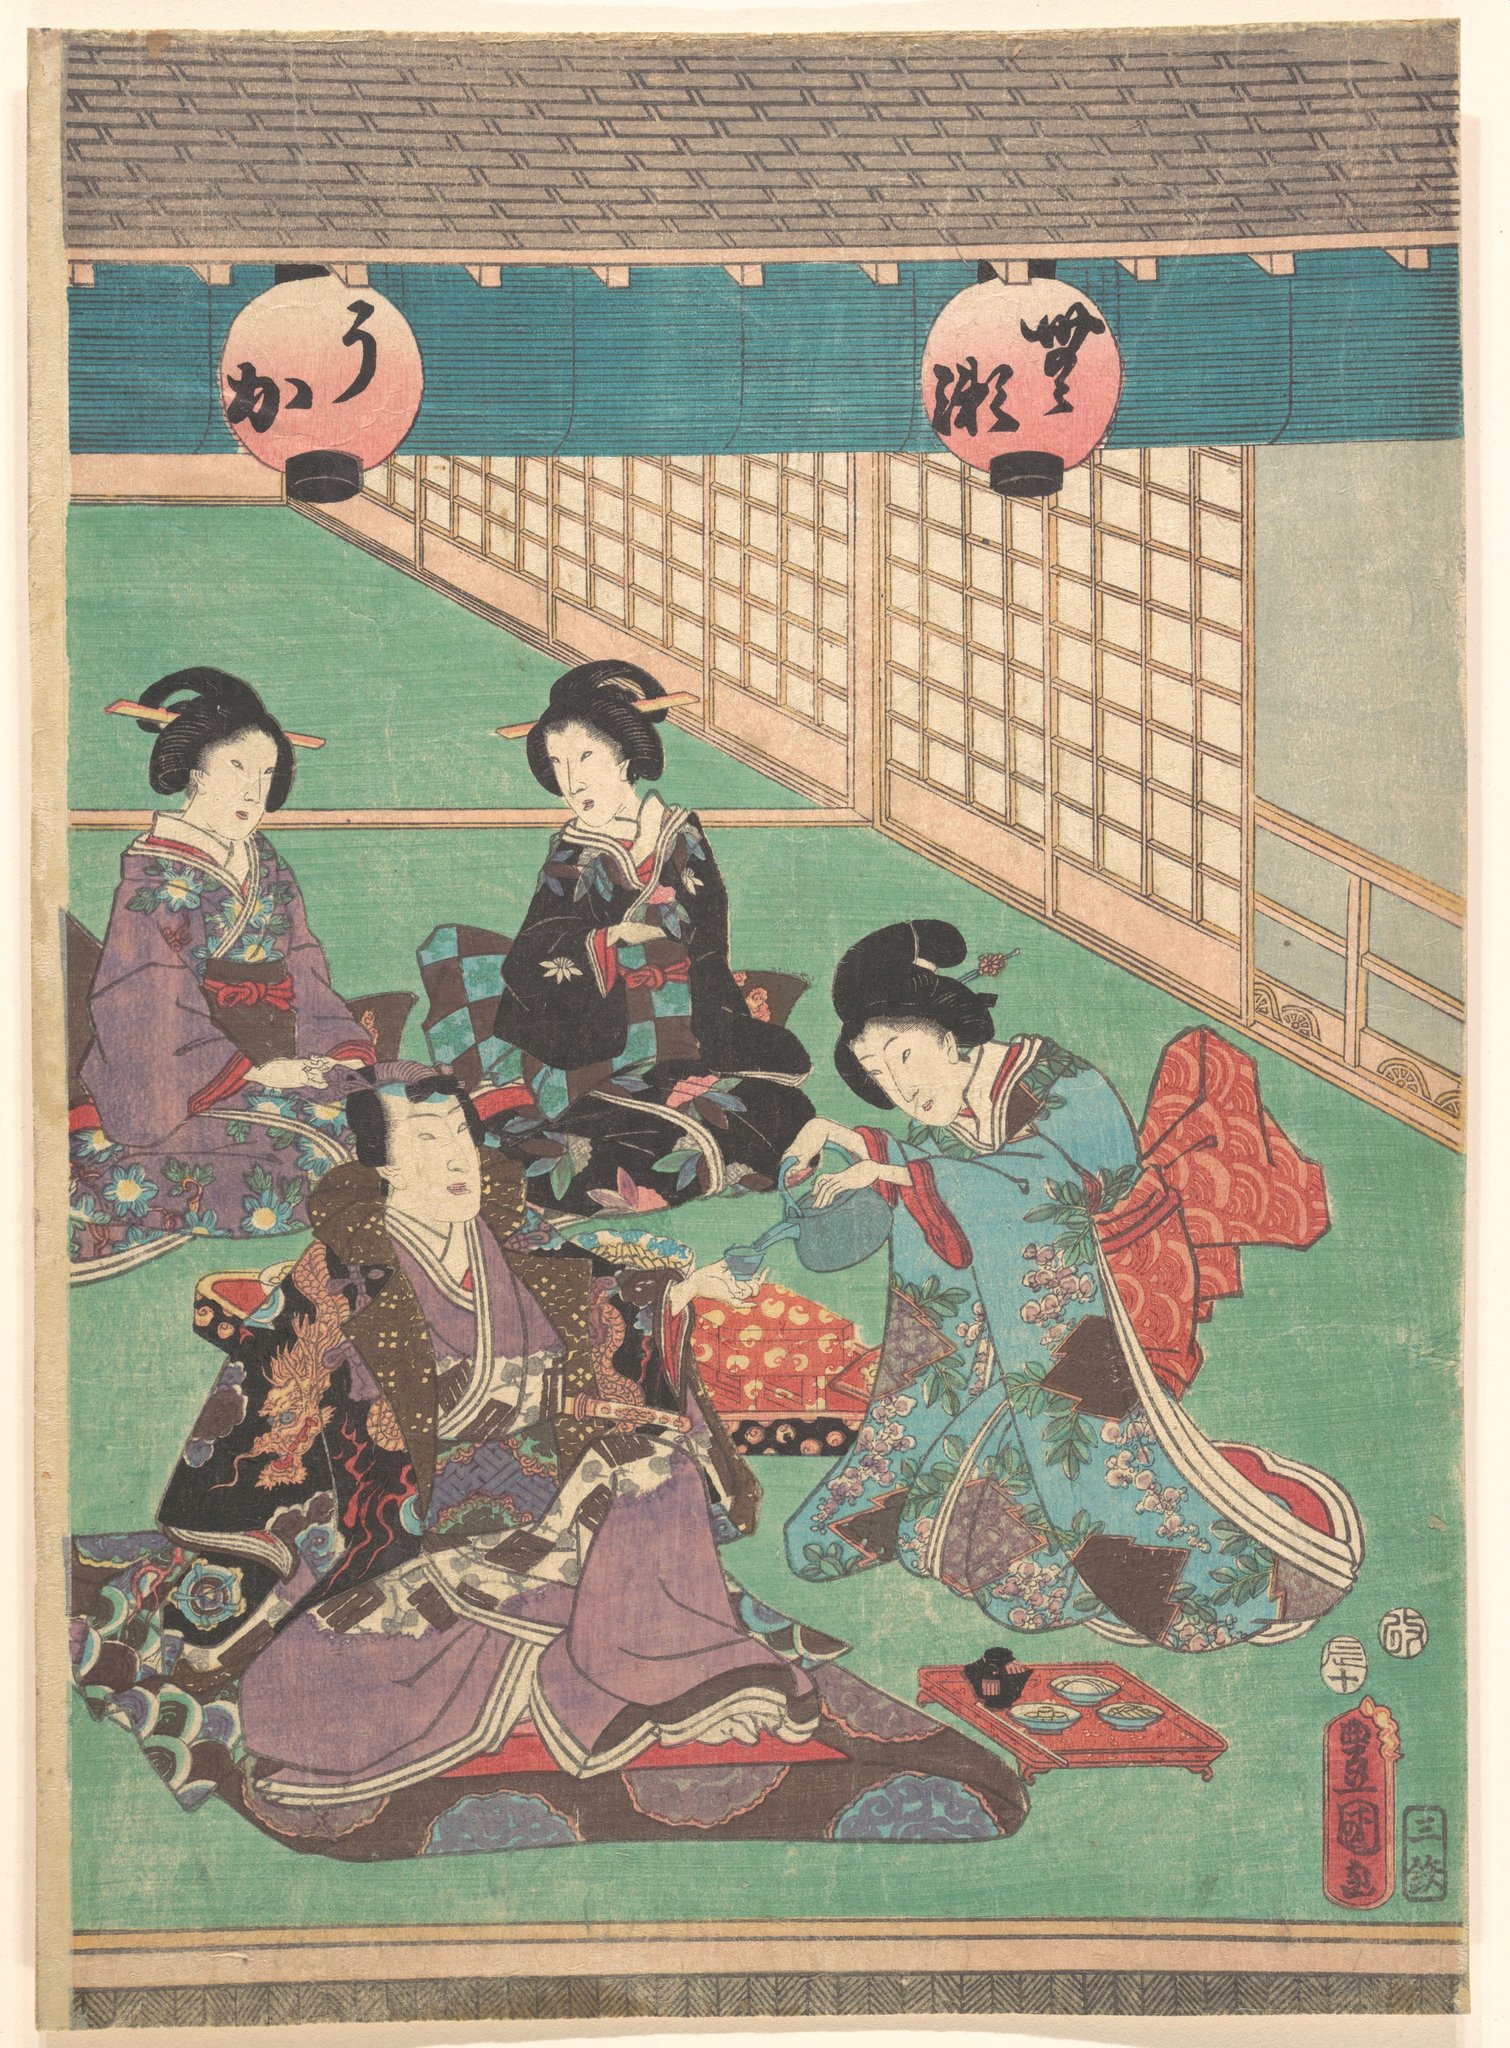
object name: print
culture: japanese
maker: utagawa kunisada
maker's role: artist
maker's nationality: japanese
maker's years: 1786-1864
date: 1786-1854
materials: ink, paper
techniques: woodblock print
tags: women